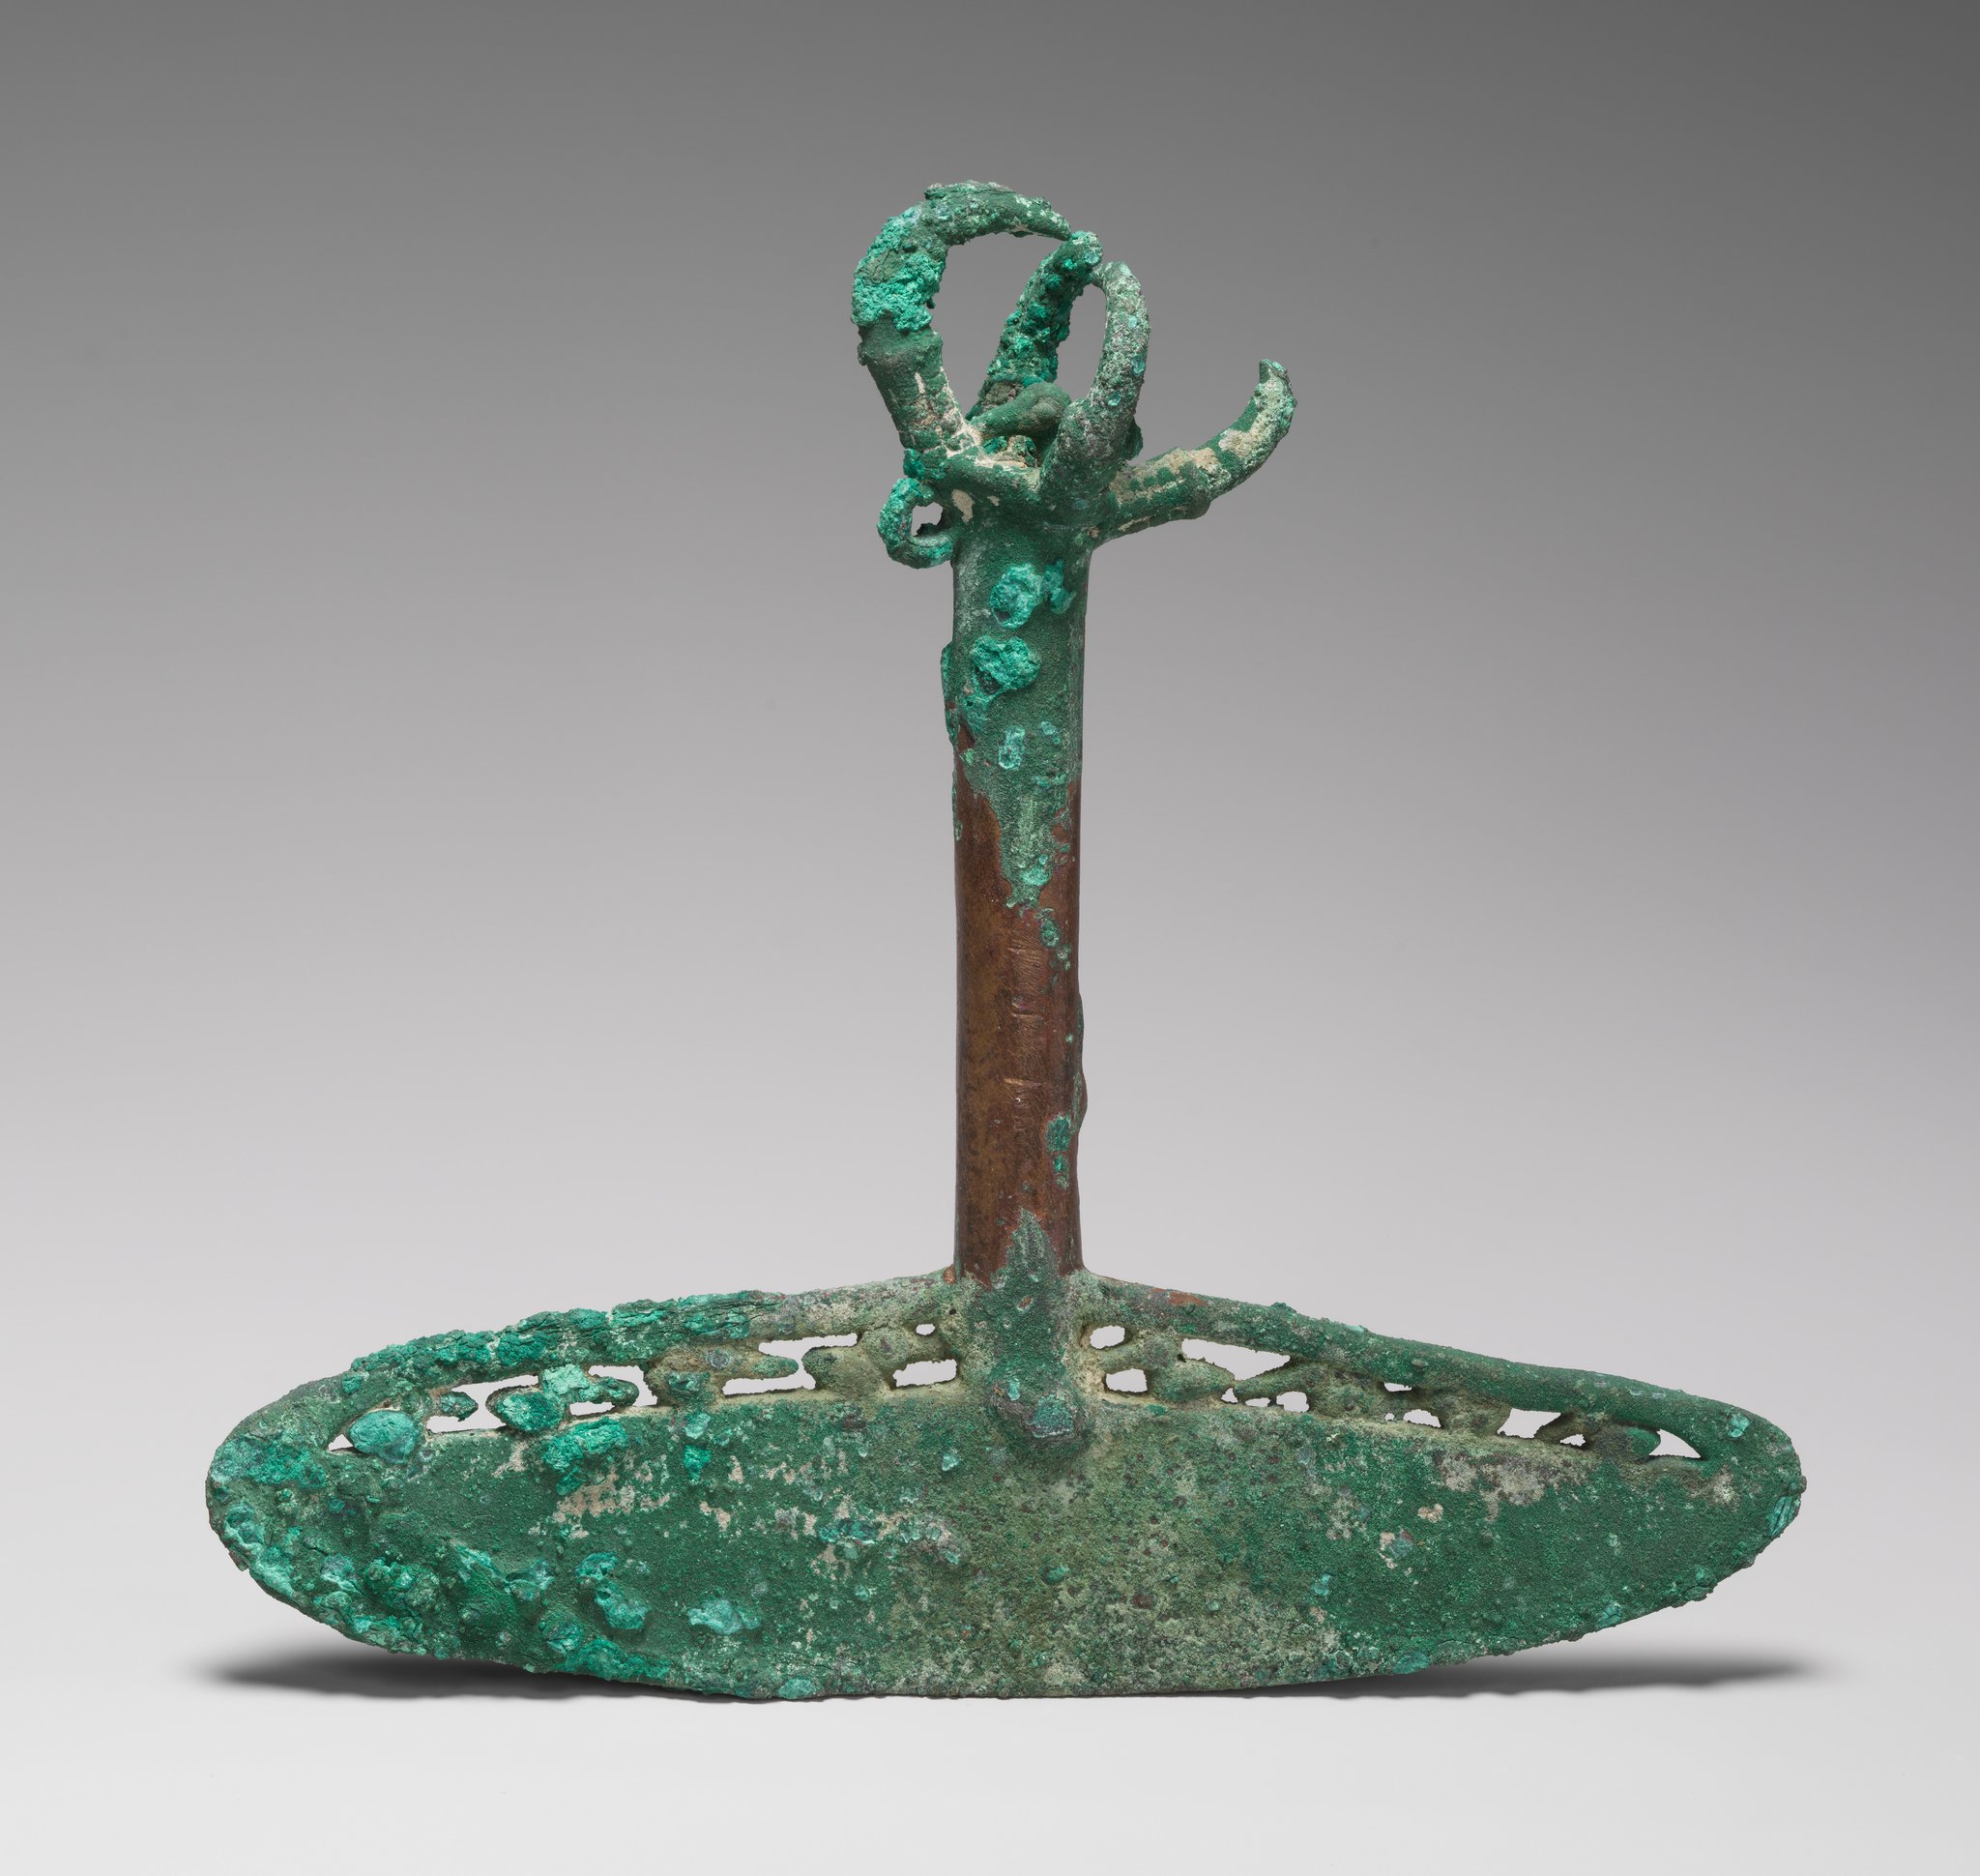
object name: knife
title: Ornamented Knife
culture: inca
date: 1401-1600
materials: copper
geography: peru